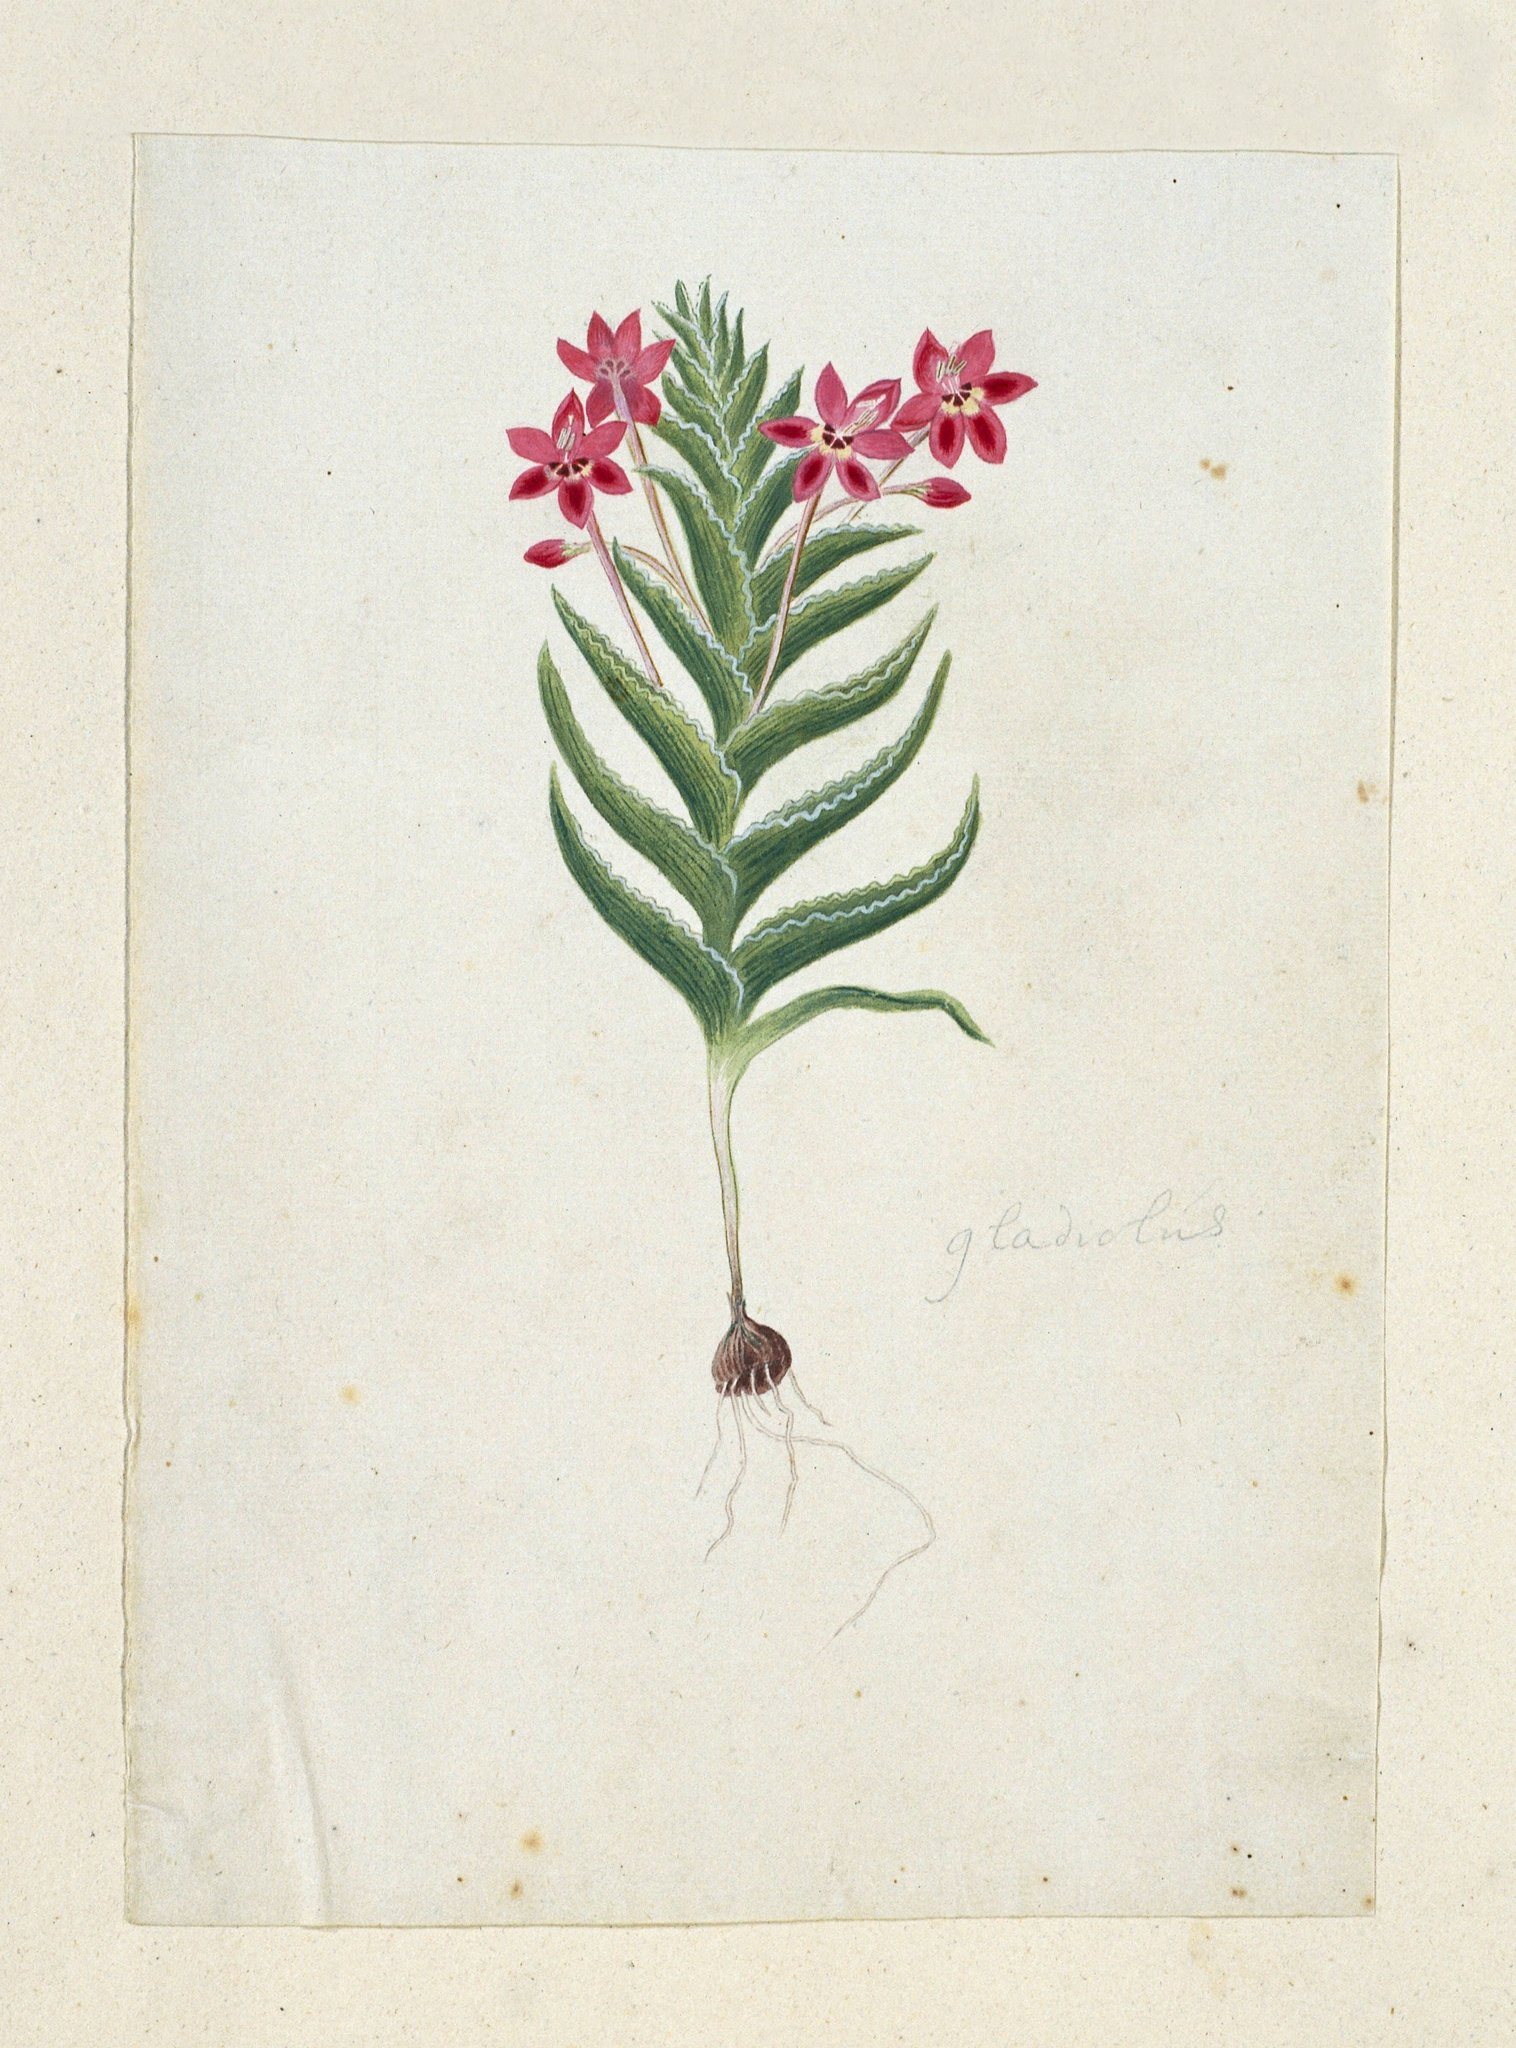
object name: album leaf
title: Lapeirousia silenoides (Jacq.) Ker Gawl.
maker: robert jacob gordon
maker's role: draughtsman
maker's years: 1743-1795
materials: chalk, paint, paper, pencil, watercolor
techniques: brush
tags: plants; vegetation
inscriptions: annotation: ‘gladiolús’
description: De tekening is gemaakt voor of tijdens een van Gordon's vier expedities door de Kaapprovincie, van oktober 1777 tot maart 1786. Sommige (soort)namen kunnen zijn gewijzigd, gezien reorganisatie in plantentaxonomie gedurende de afgelopen jaren.